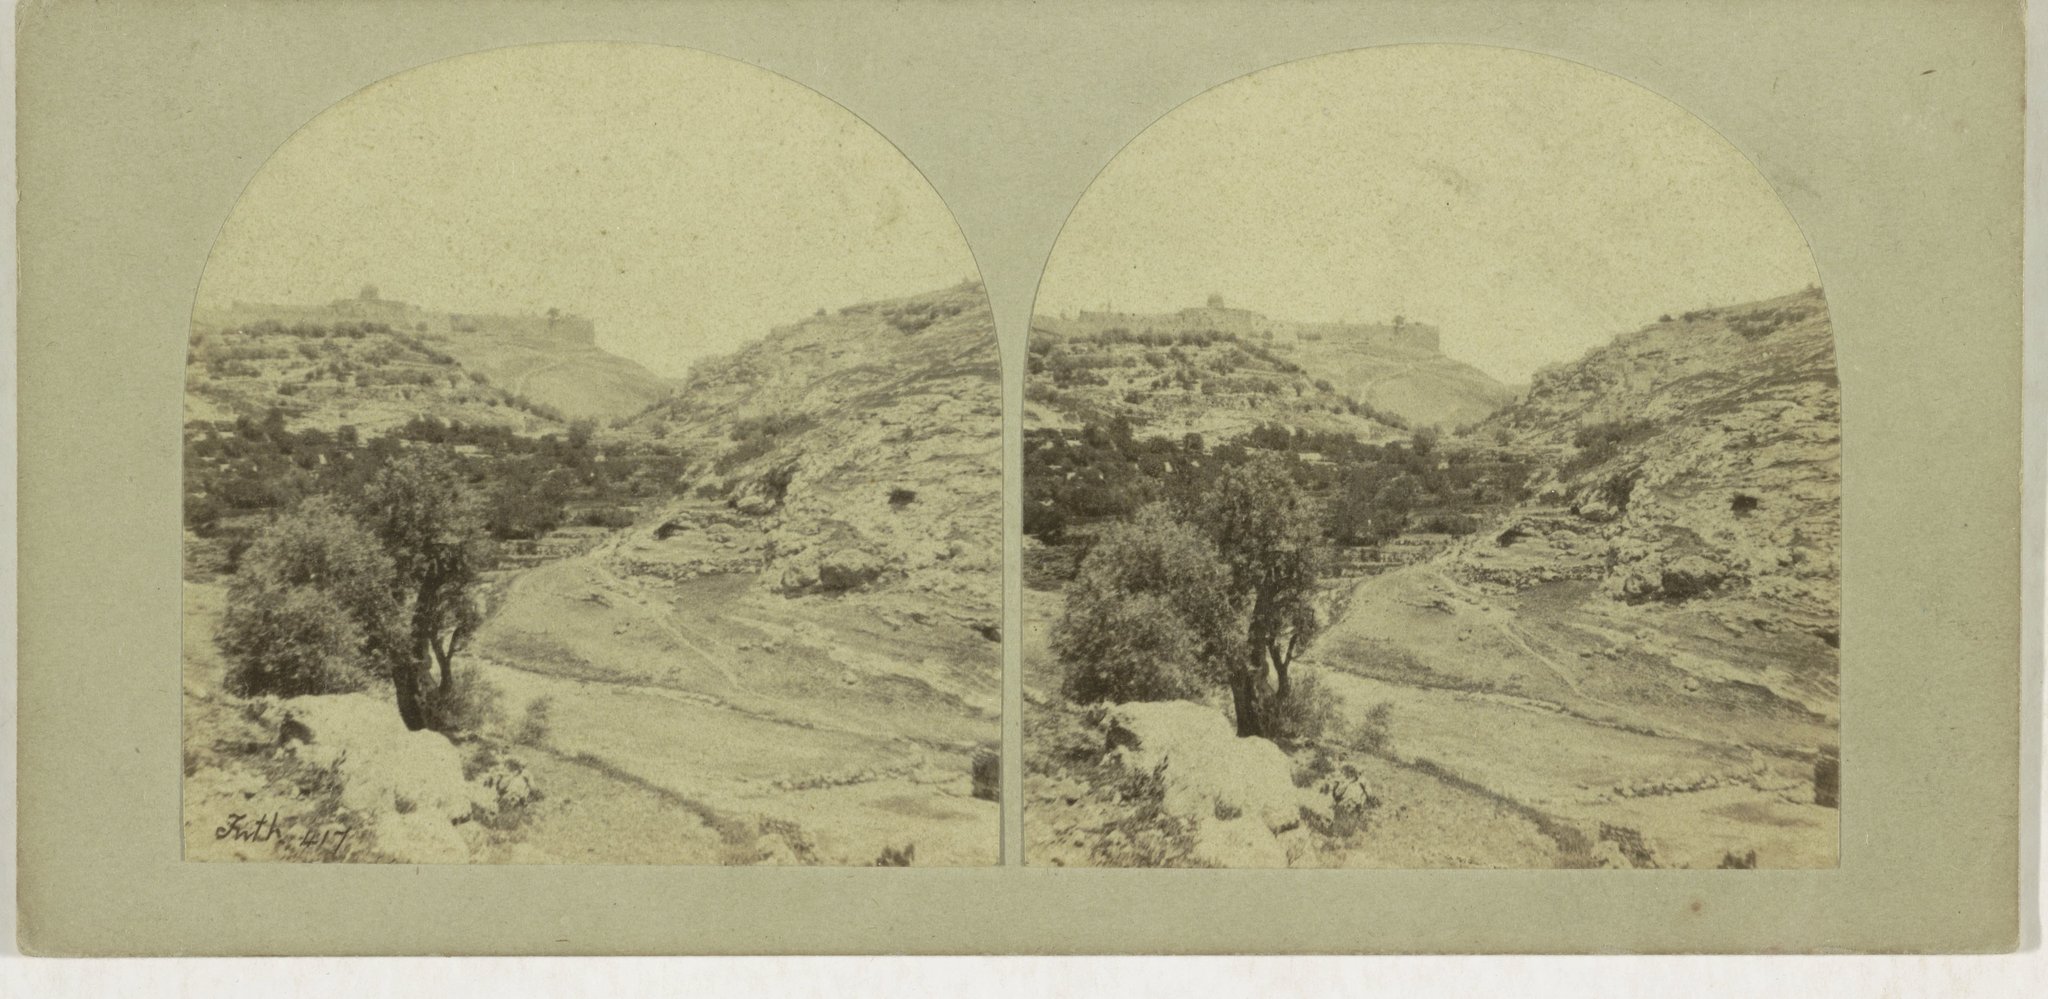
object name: stereograph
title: Views in the Holy Land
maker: francis frith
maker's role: publisher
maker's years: 1822-1898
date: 1858-1859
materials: cardboard, paper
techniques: albumen print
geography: london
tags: city-view in general; 'veduta'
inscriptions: inscription: ‘Entered at Stationers' Hall.]’, number: ‘417’, inscription: ‘THE first hill to the right is the Hill of Offence, so called from Solomon having erected theron pagan/ temples for his foreign wives. Part of the village (...)’, inscription: ‘Taken from the south-east, from a little to the left of En Rogel.’, inscription: ‘[Deposé.’